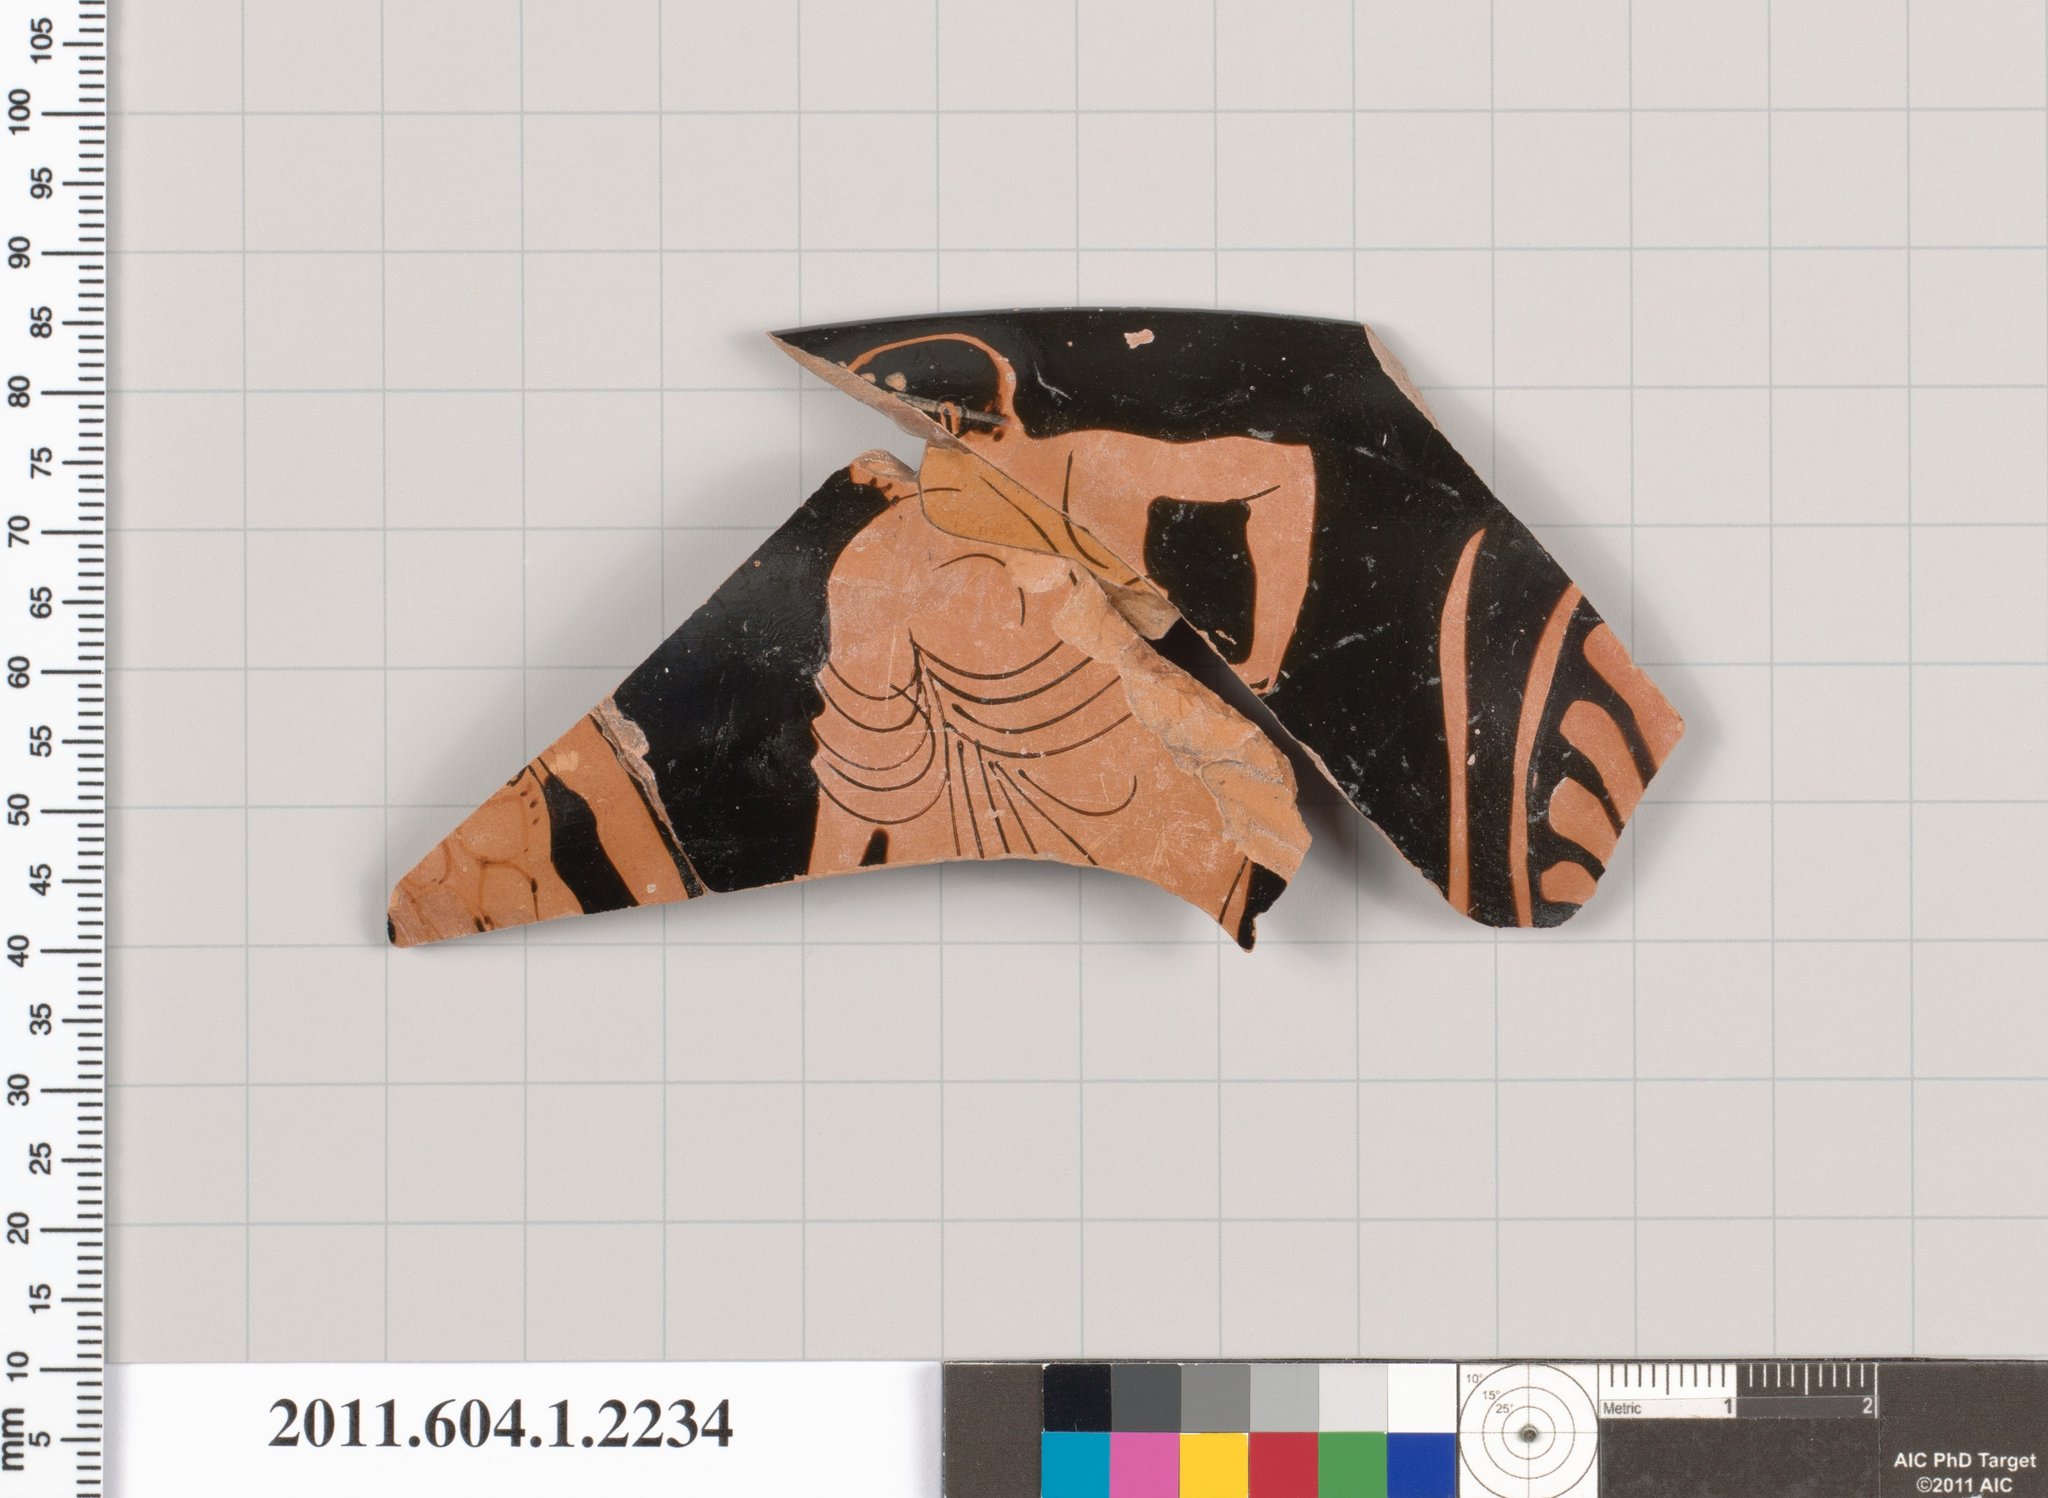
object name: kylix fragment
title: Terracotta rim fragment of a kylix (drinking cup)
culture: greek, attic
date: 470-450 BCE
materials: terracotta